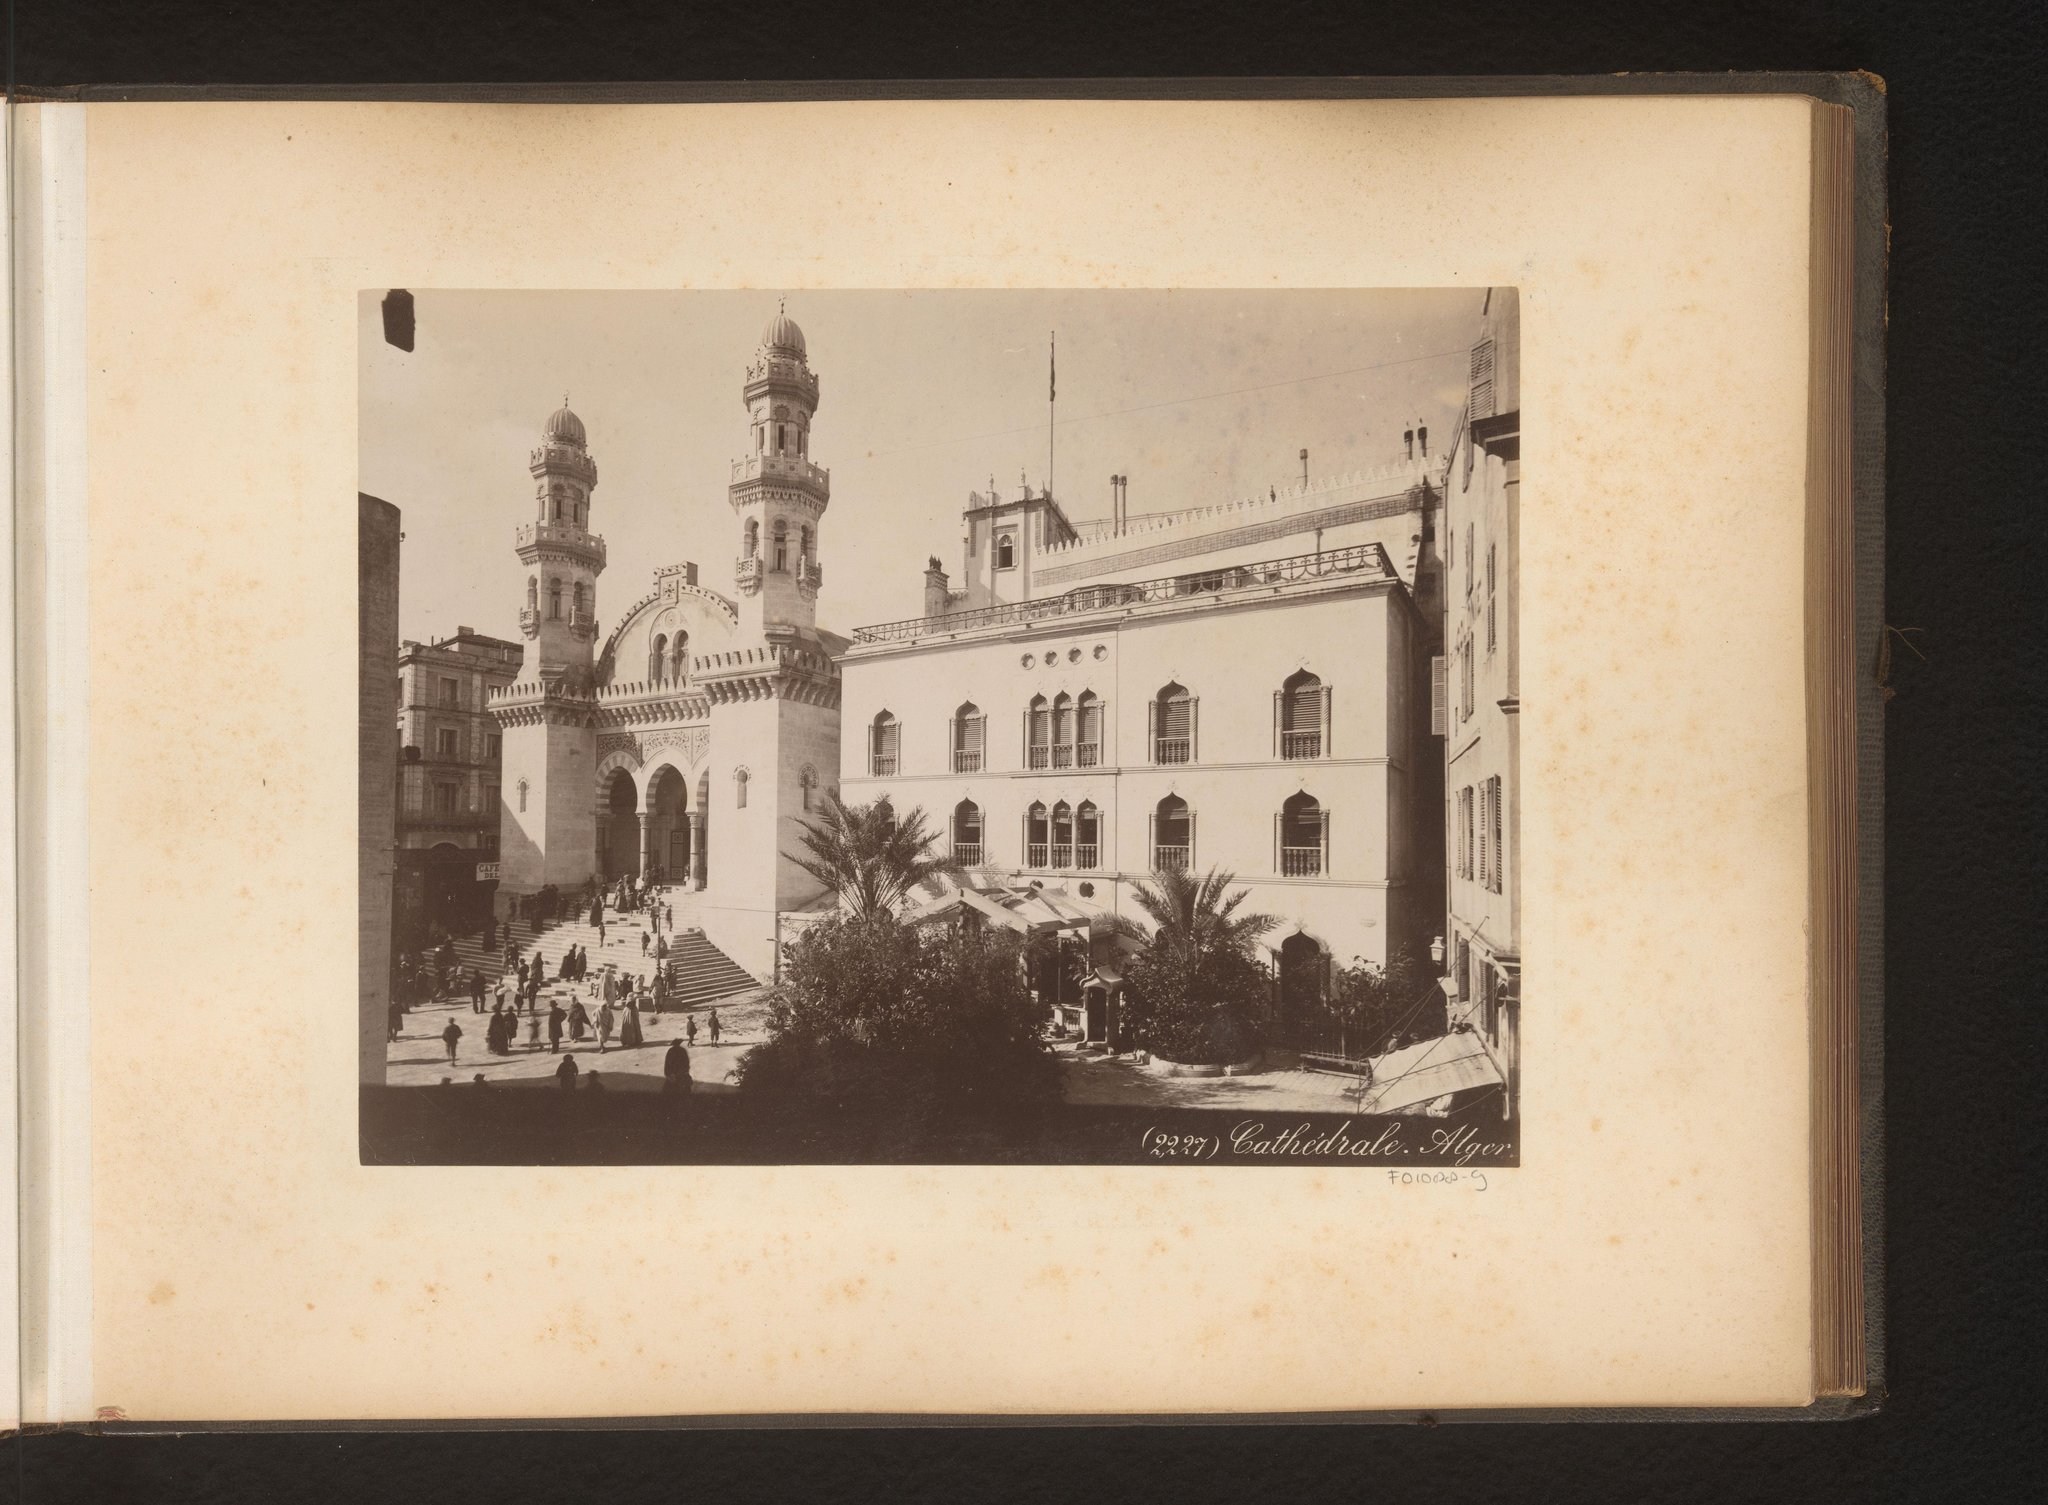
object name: photograph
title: Gezicht op een kathedraal te Algiers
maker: Anonymous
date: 1880-1900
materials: photographic support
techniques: albumen print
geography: algiers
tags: church (exterior)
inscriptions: number: ‘2227’